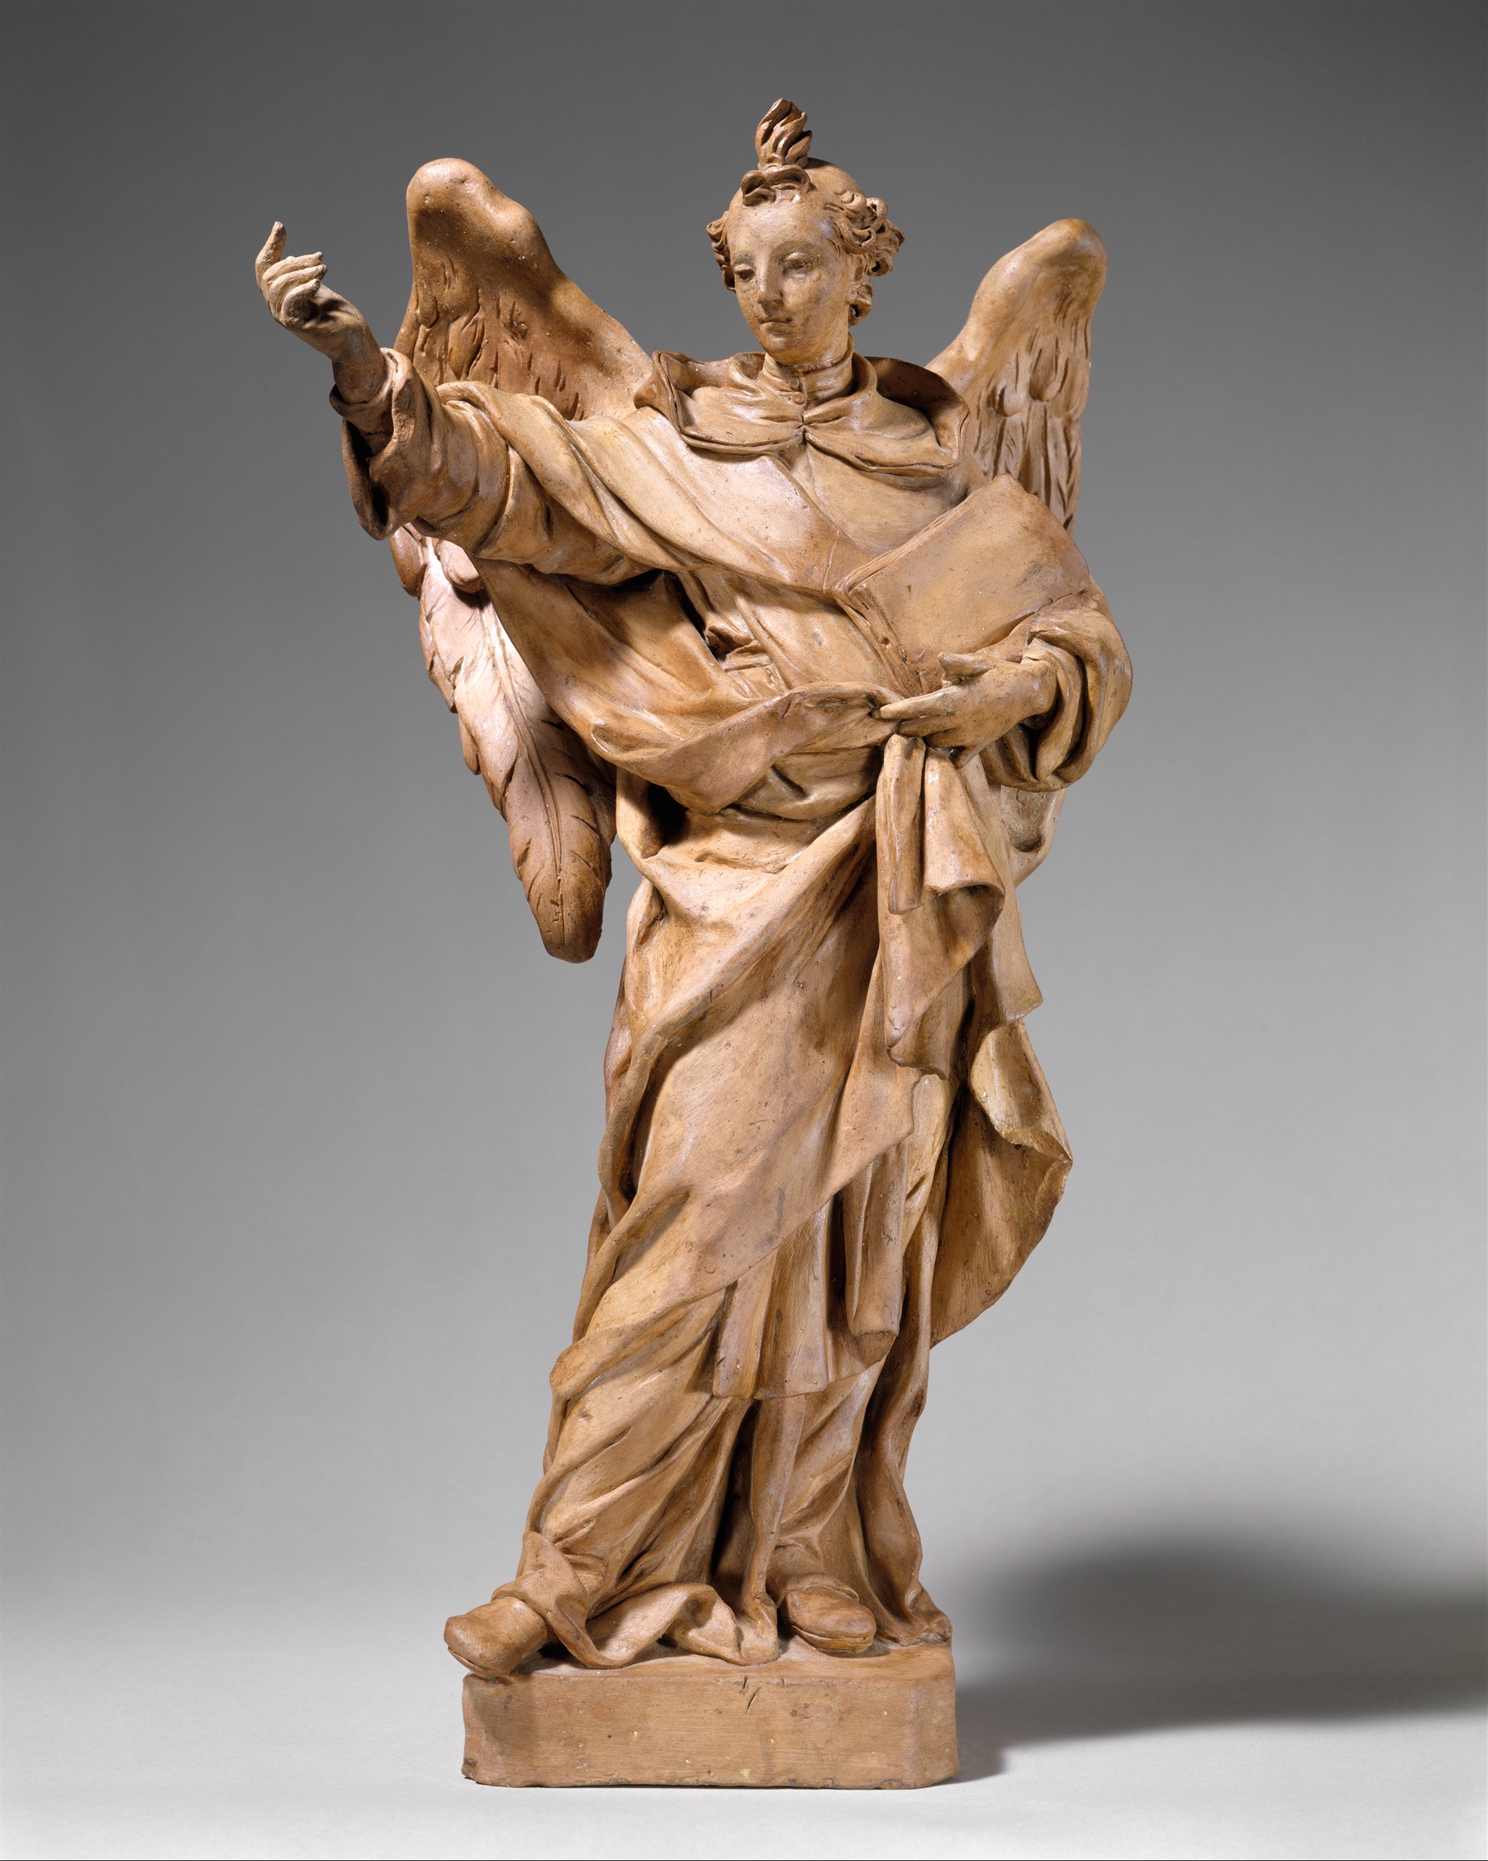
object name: model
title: Saint Vincent Ferrer (1350–1419)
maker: giuseppe sanmartino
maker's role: artist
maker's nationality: italian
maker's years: 1720-1793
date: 1750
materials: terracotta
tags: saints